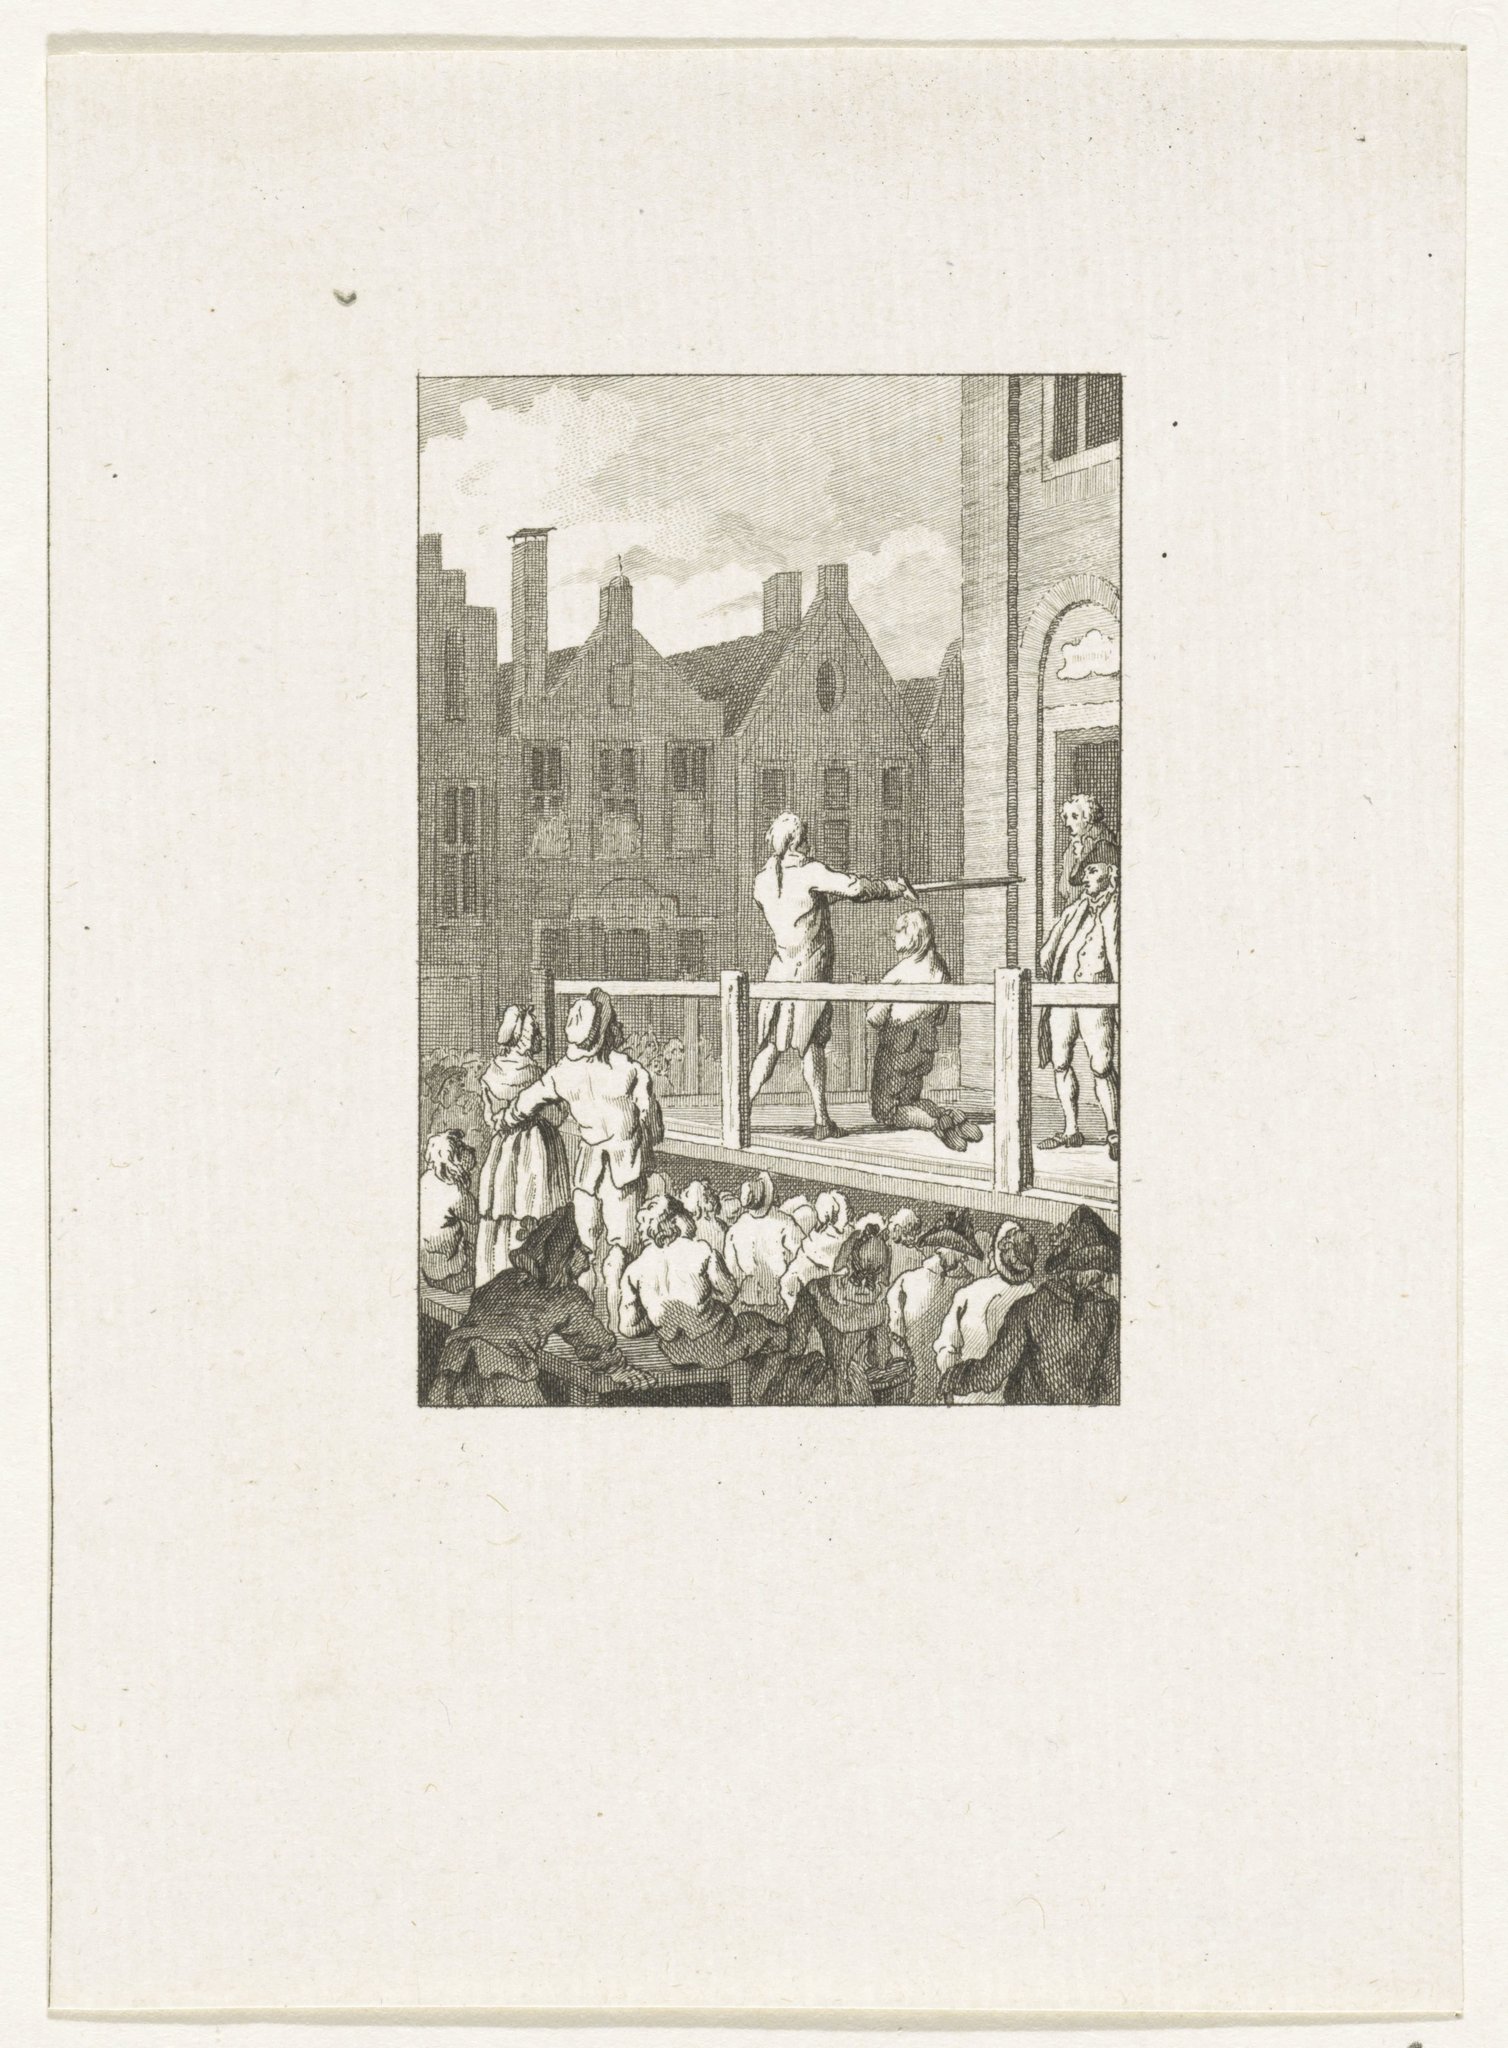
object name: print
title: Terechtstelling van burgemeester Cornelis van der Burgh te Leeuwarden, 1789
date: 1789-1795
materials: paper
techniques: engraving, etching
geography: northern netherlands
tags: pardon, reprieve, violent death by hanging, patriots (1780-1795)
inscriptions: collector's mark: Lugt 2228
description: Terechtstelling van Cornelis van der Burg, uitgesproken patriotse burgemeester van Bolsward, te Leeuwarden op 16 mei 1789. Als de burgemeester geblinddoekt knielt op het schavot houdt de beul het zwaard boven zijn hoofd en wordt het doodsvonnis omgezet in een verbanning van twintig jaar.